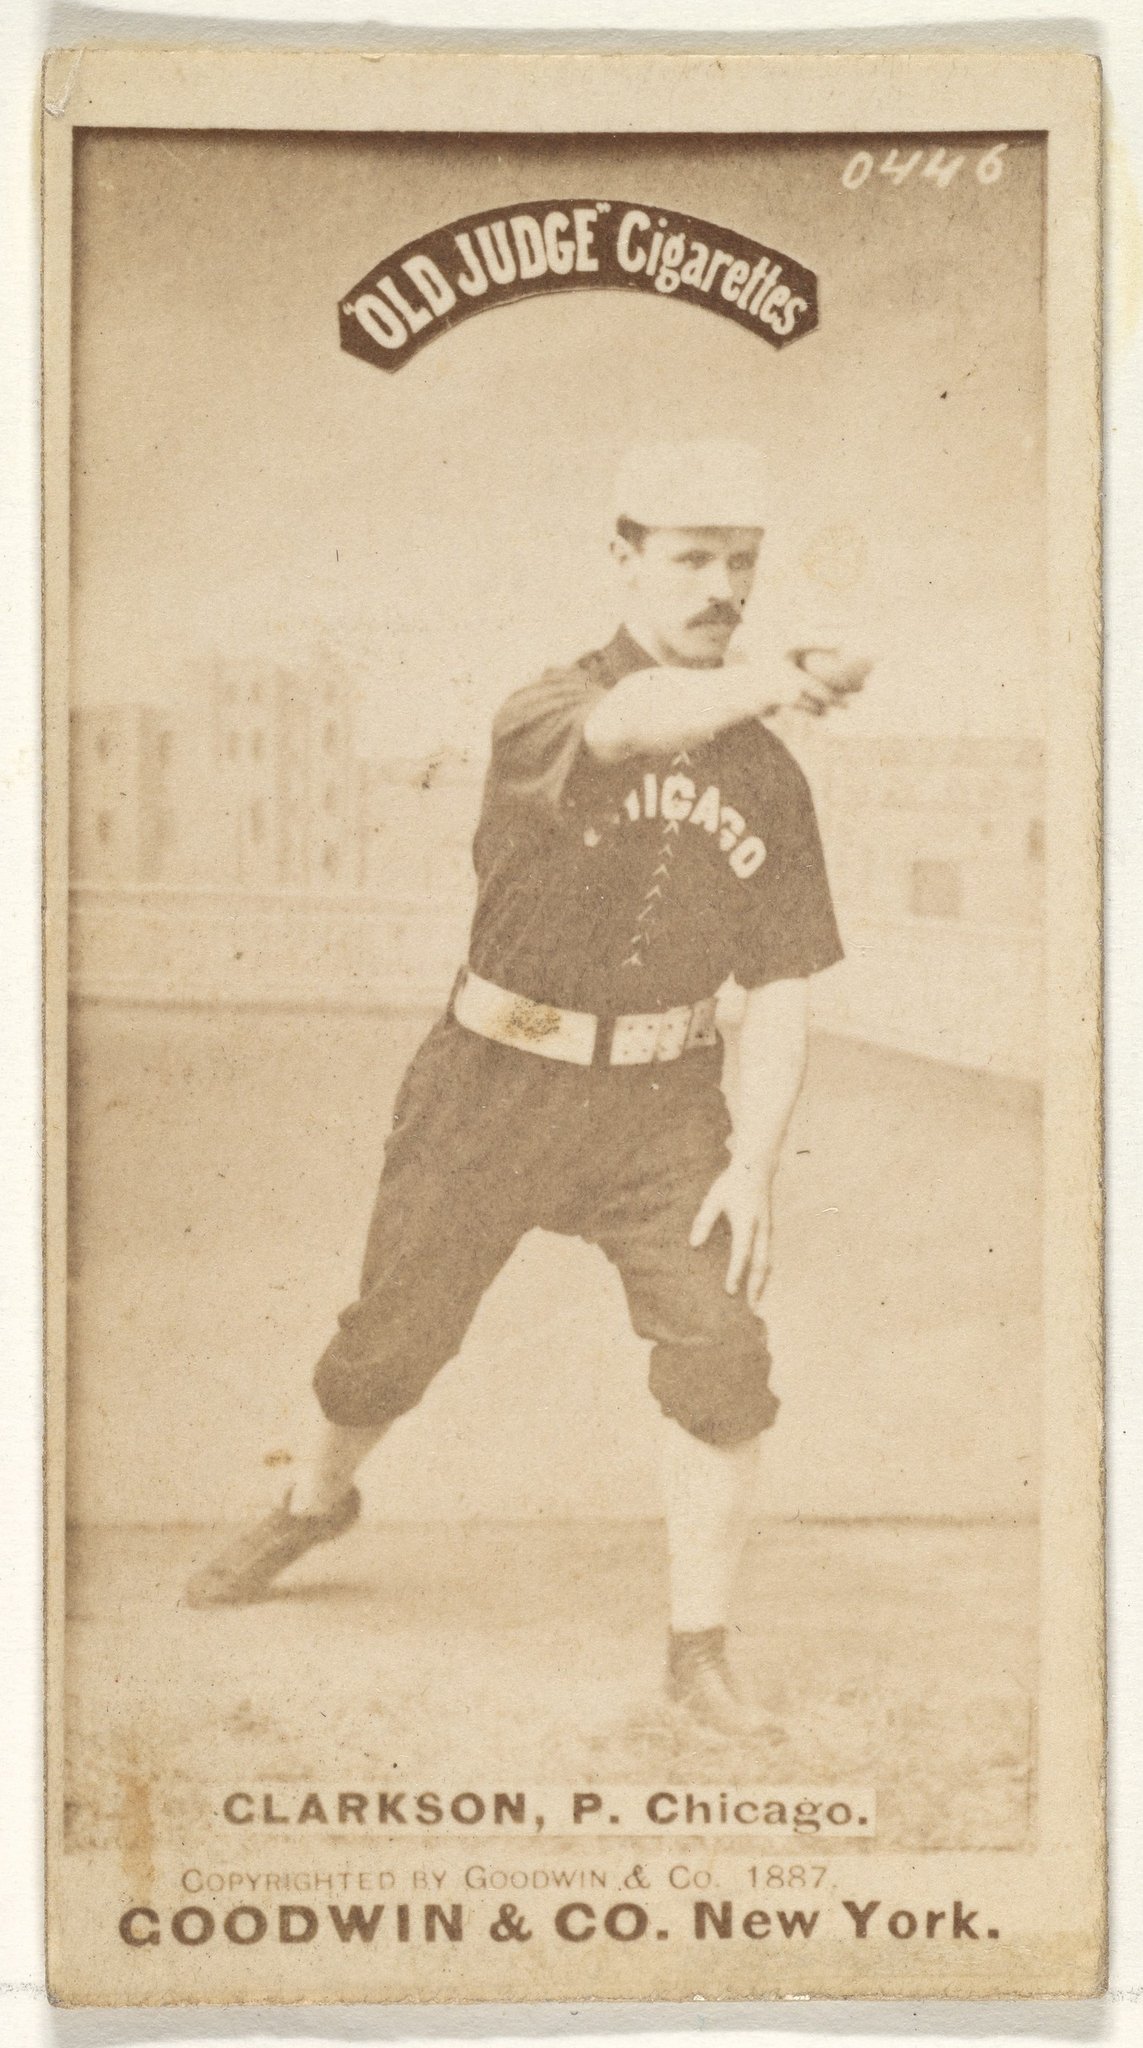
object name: baseball card, photograph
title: Clarkson, Pitcher, Chicago, from the Old Judge series (N172) for Old Judge Cigarettes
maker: goodwin & company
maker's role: publisher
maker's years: 1850-1950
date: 1887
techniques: albumen silver print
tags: men,portraits,baseball,athletes